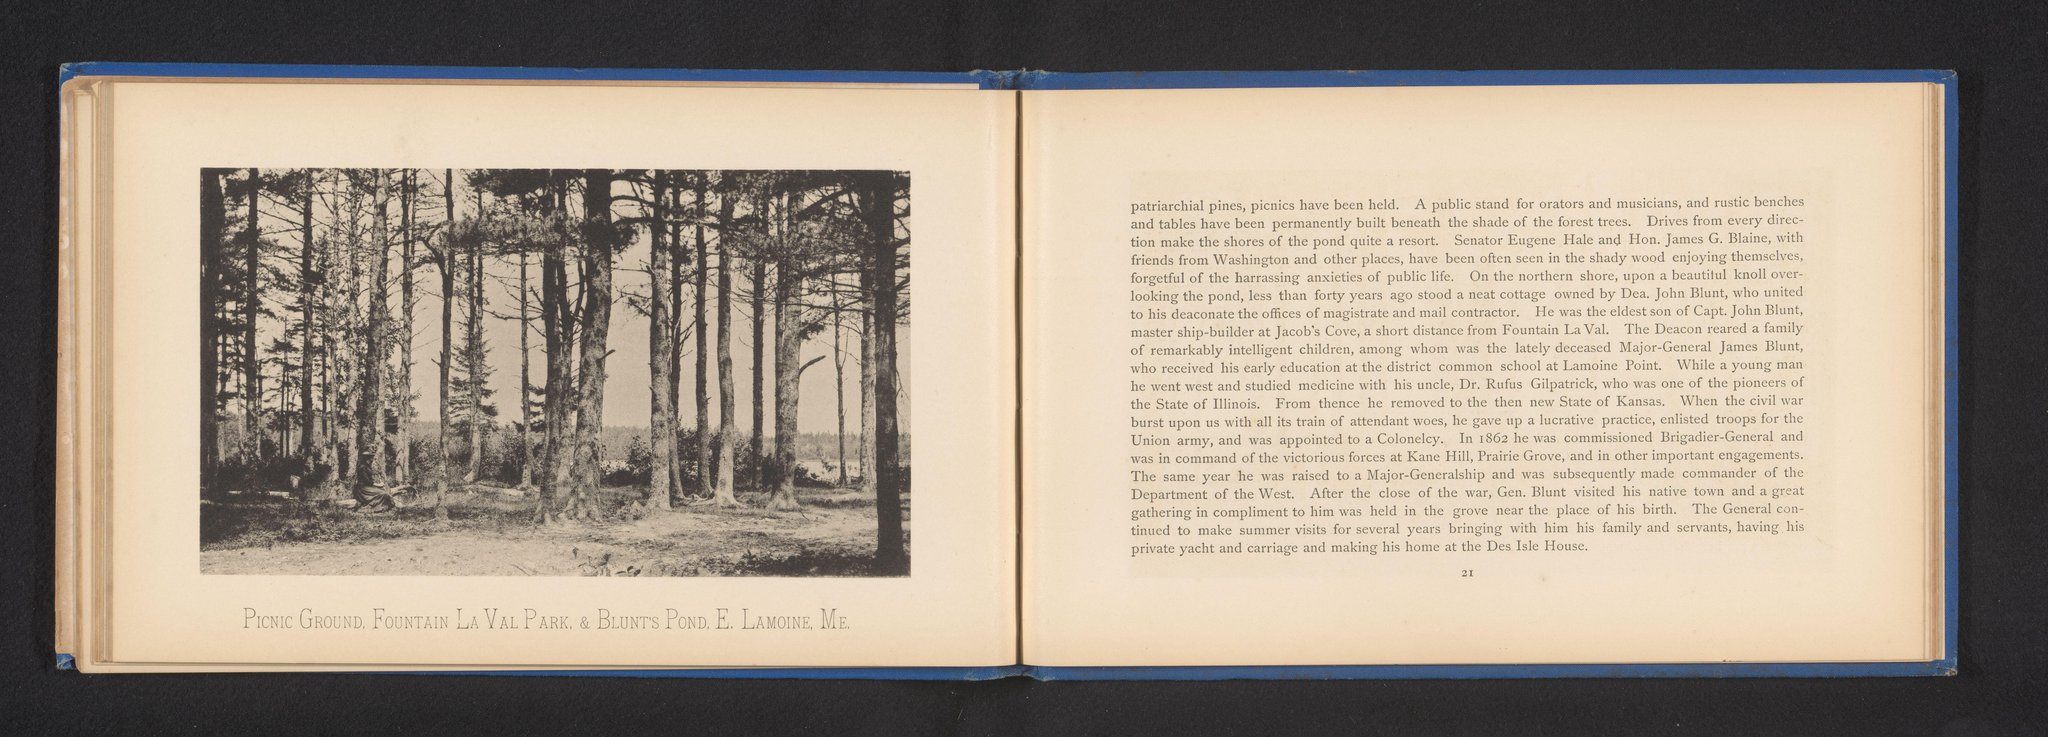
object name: page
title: Picnic ground, Fountain La Val Park, & Blunt's Pond, E. Lamoine, Me.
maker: Anonymous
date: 1882-1887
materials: paper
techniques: photograph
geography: east lamoine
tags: landscapes, historical persons - bb - woman, pond, pool